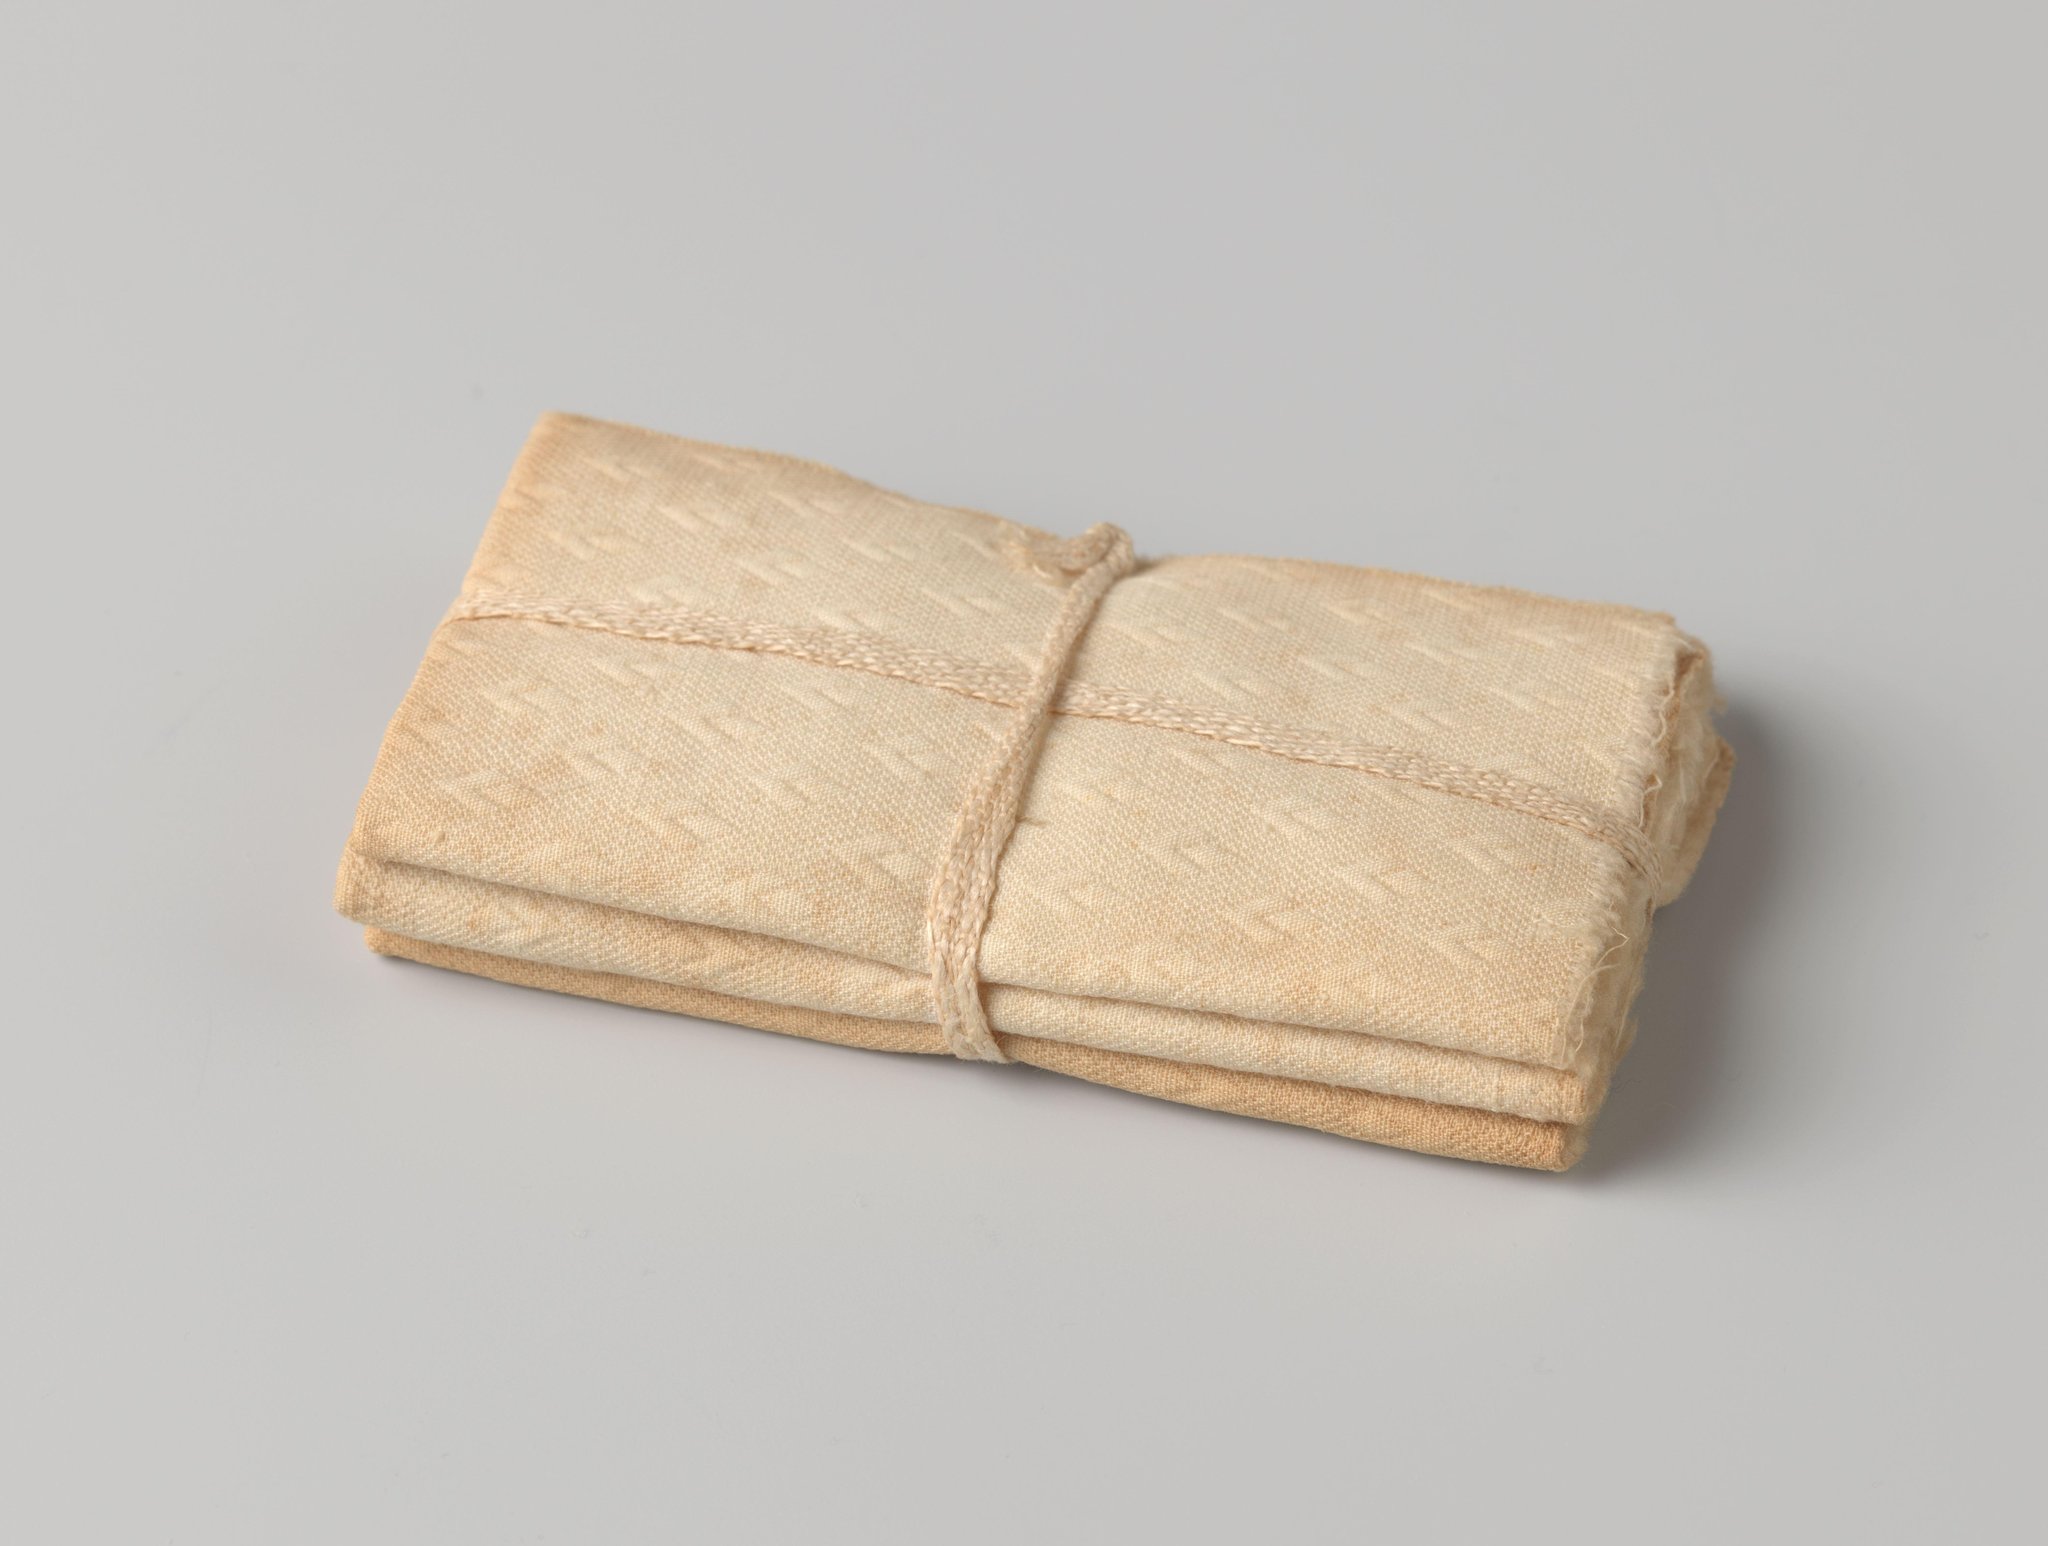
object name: miniature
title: Stapel van drie dekens, samengebonden met band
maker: Anonymous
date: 1750-1800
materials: cotton, linen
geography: netherlands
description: Een stapel van drie opgevouwen en met linnen band samengebonden dekens (?) vervaardigd van katoen dubbelweefsel met ingeweven ruitmotief. De achterkant is geruwd.